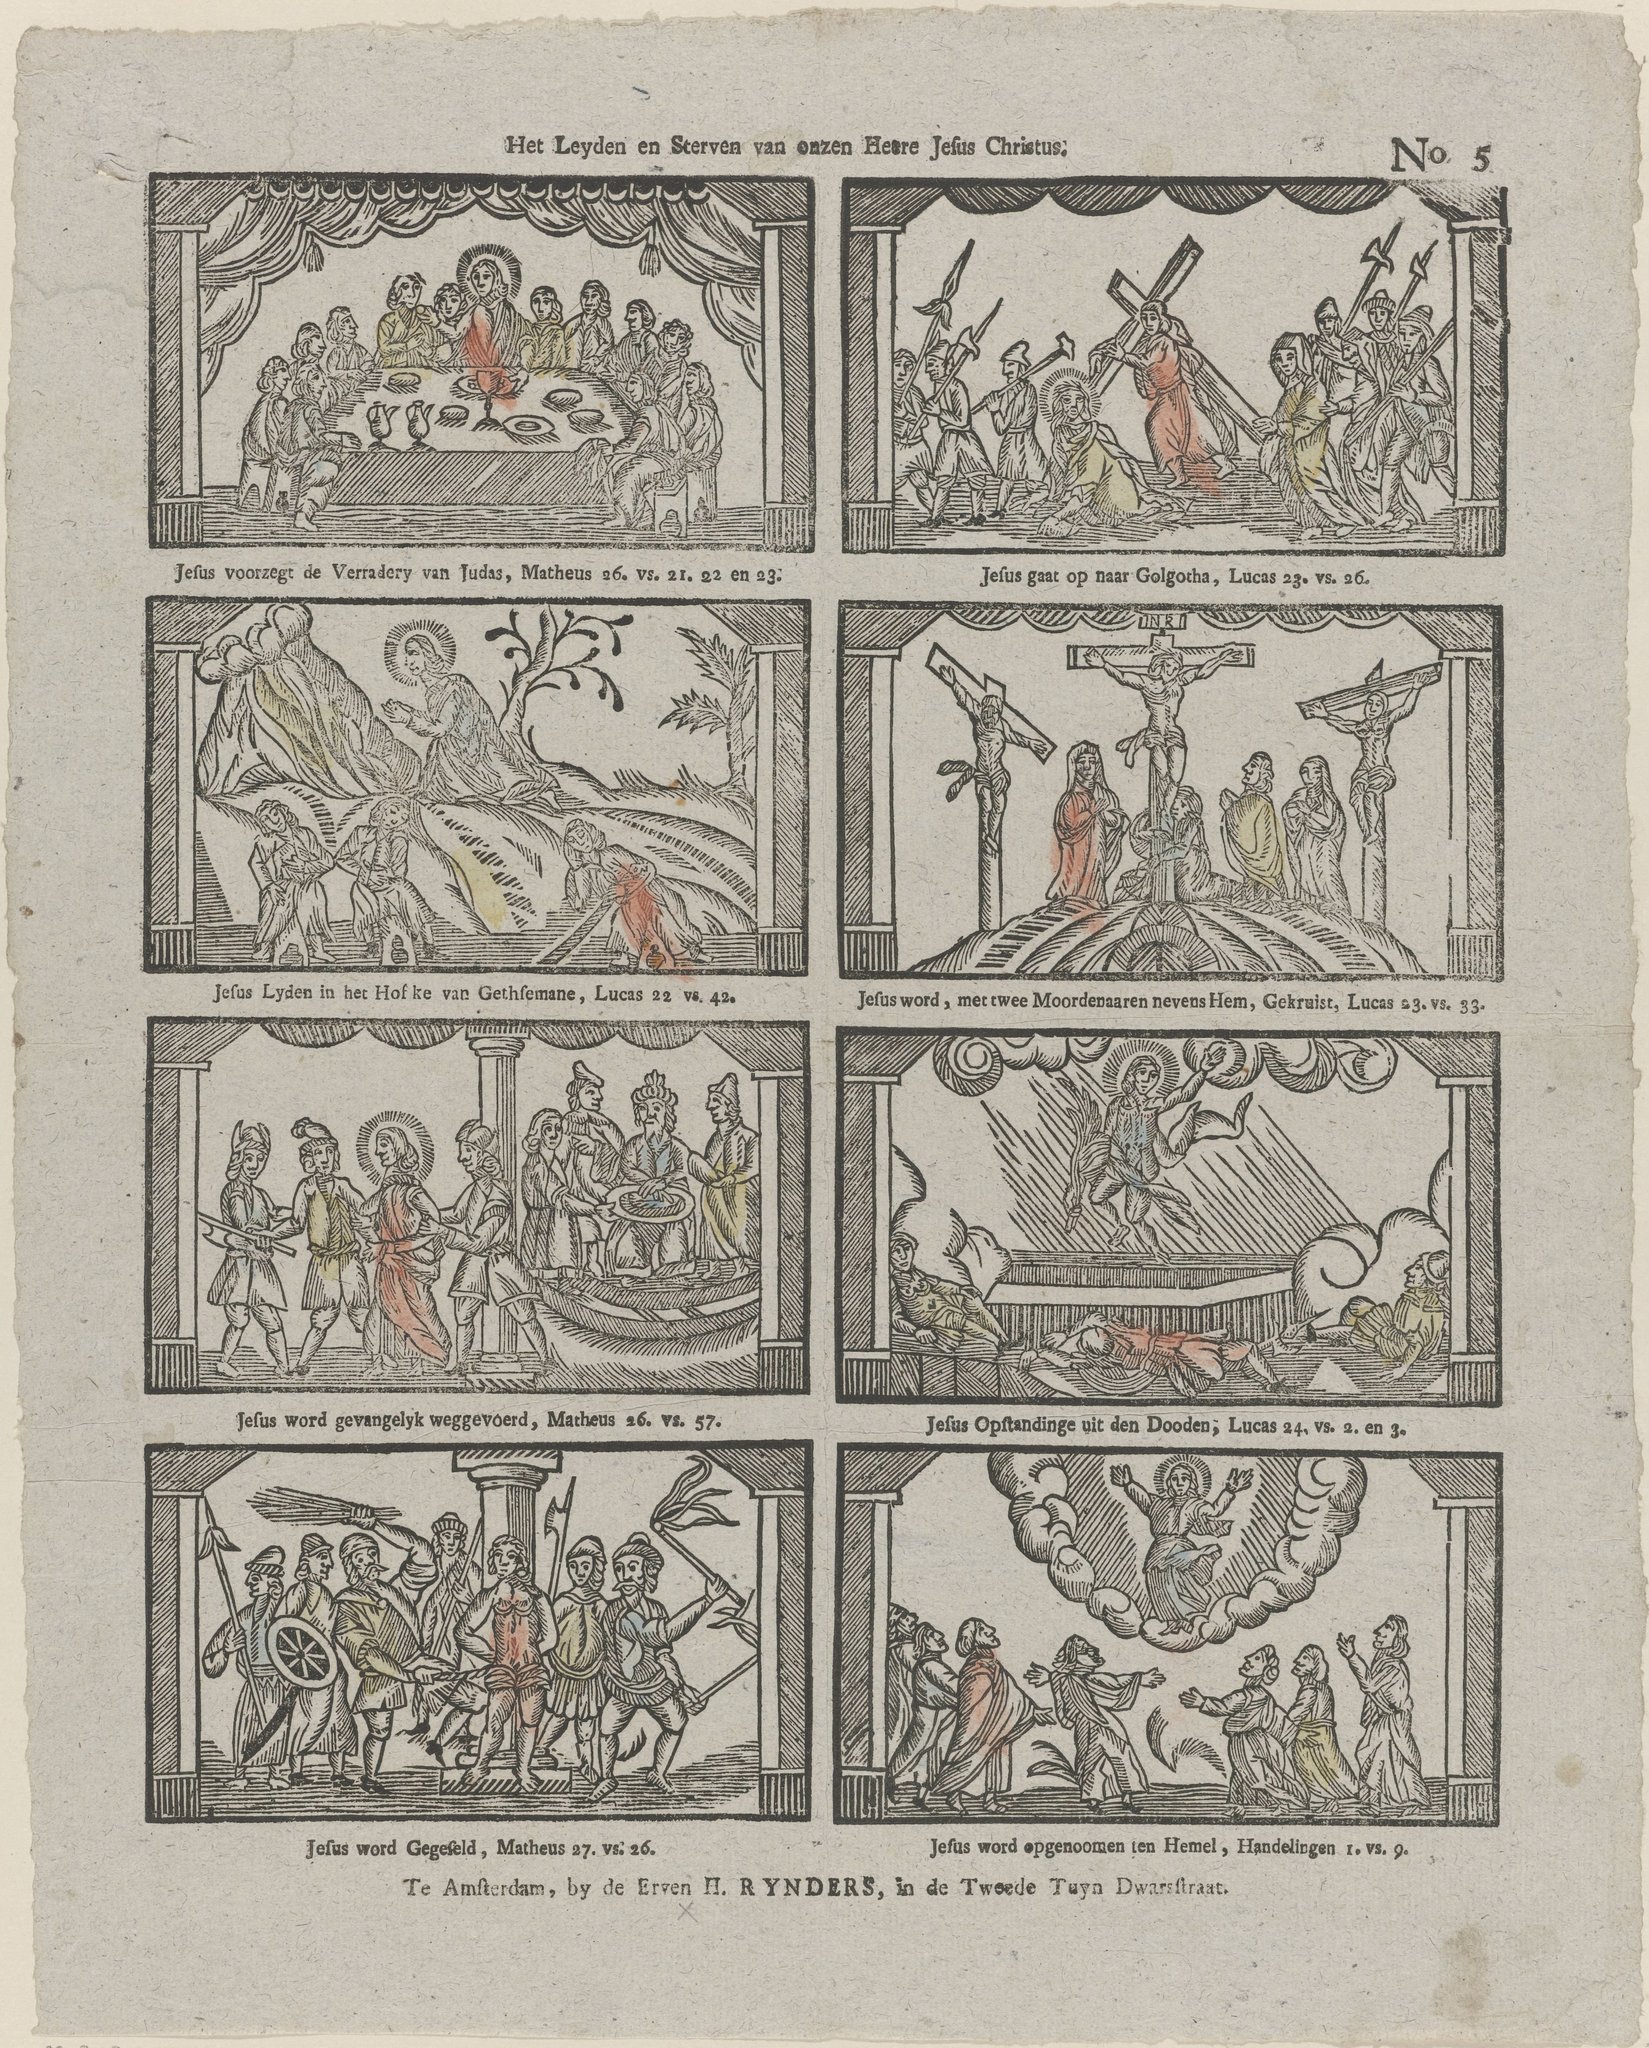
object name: print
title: Het leyden en sterven van onzen heere Jesus Christus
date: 1831-1854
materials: paper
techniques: colour, letterpress printing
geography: amsterdam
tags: the episode of the last supper, new testament, christ taken up by a cloud ~ ascension, series of scenes from the life of christ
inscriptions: collector's mark: Lugt 2760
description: Blad met 8 voorstellingen uit het leven van Christus, zoals het Laatste Avondmaal, de Kruisdraging en de hemelvaart van Christus. Onder elke voorstelling een onderschrift en een verwijzing naar de bijbehorende Bijbeltekst. Genummerd rechtsboven: No. 5.